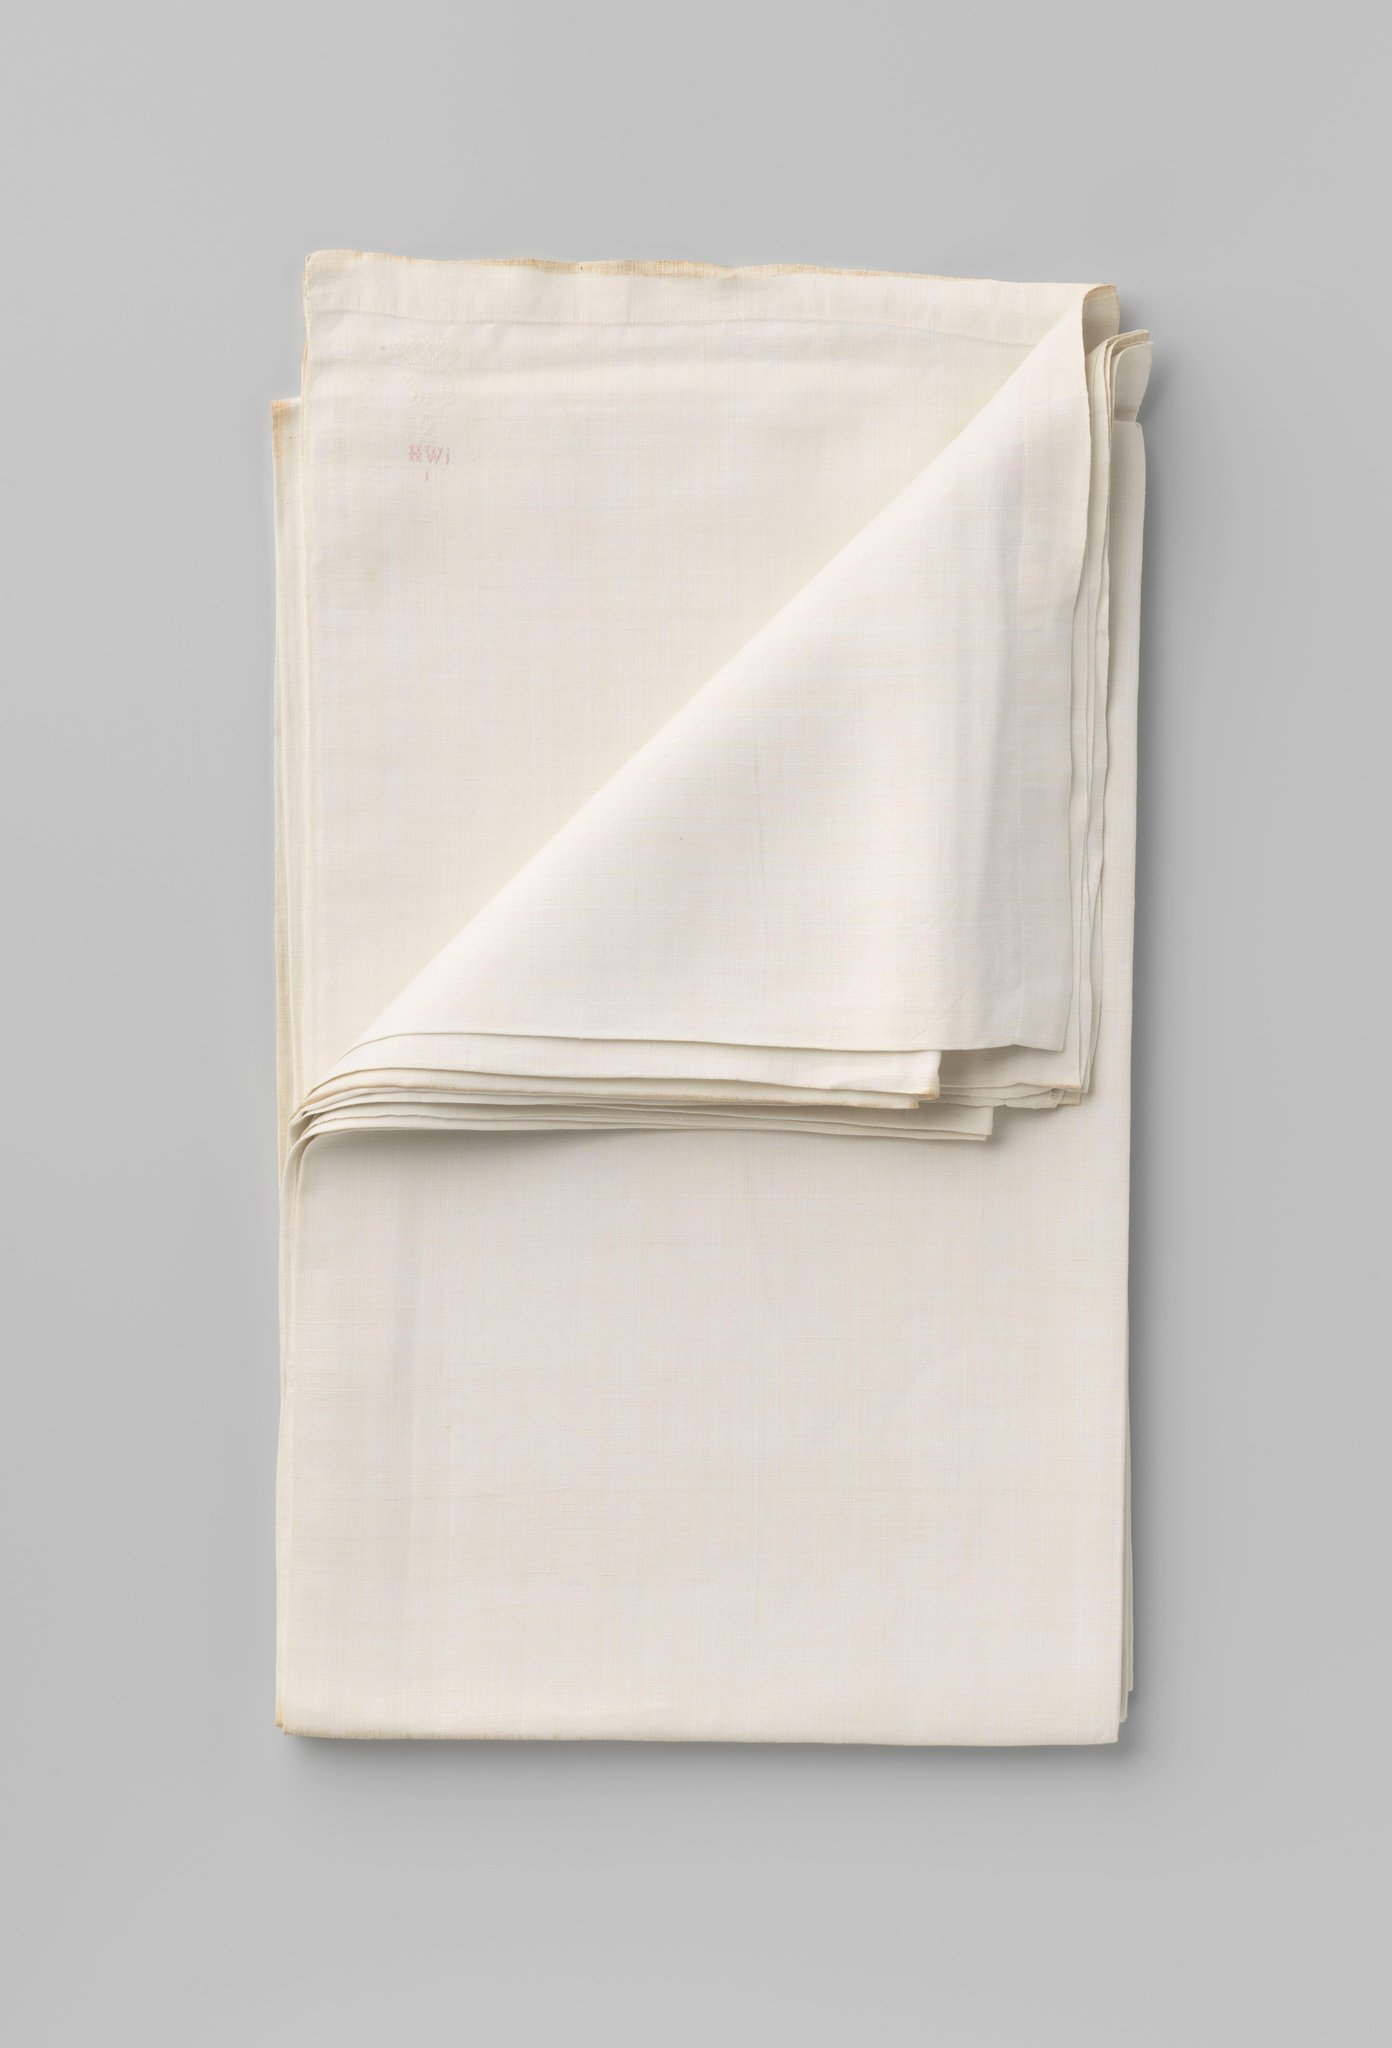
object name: beddenlaken, laken object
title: Laken. Merk: kroon WG2 en HW11.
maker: Anonymous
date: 1723-1769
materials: linen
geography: northern netherlands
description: Laken van wit linnen, merk kroon WG 2 HW1 1